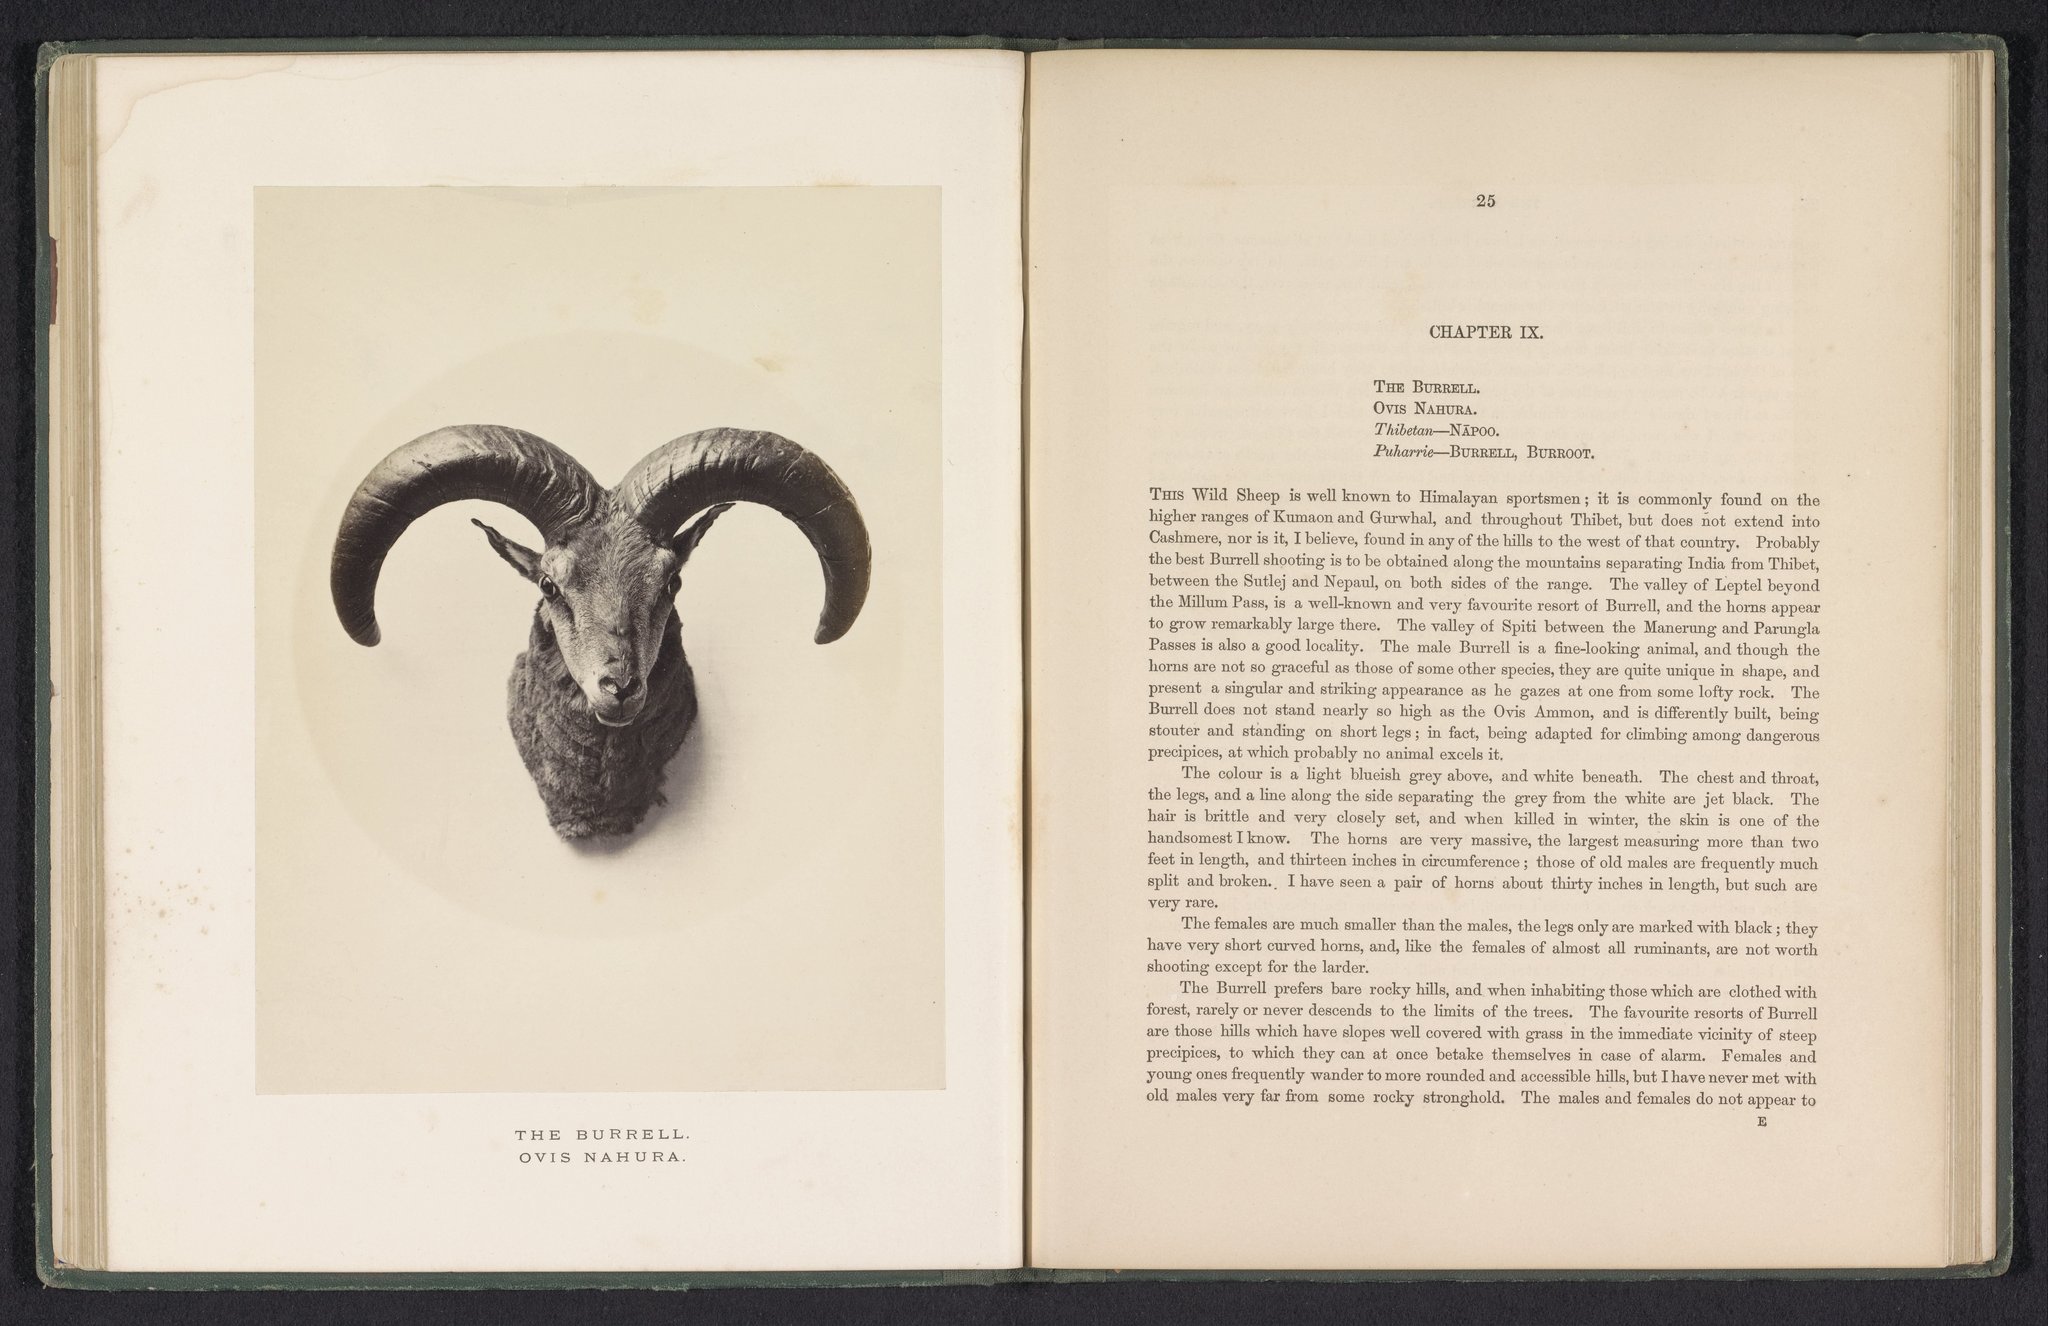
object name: photograph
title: The burrell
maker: arthur lucas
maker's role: fotograaf, handelaar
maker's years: 1842-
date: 1859-1869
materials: photographic support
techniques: albumen print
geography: london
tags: sheep